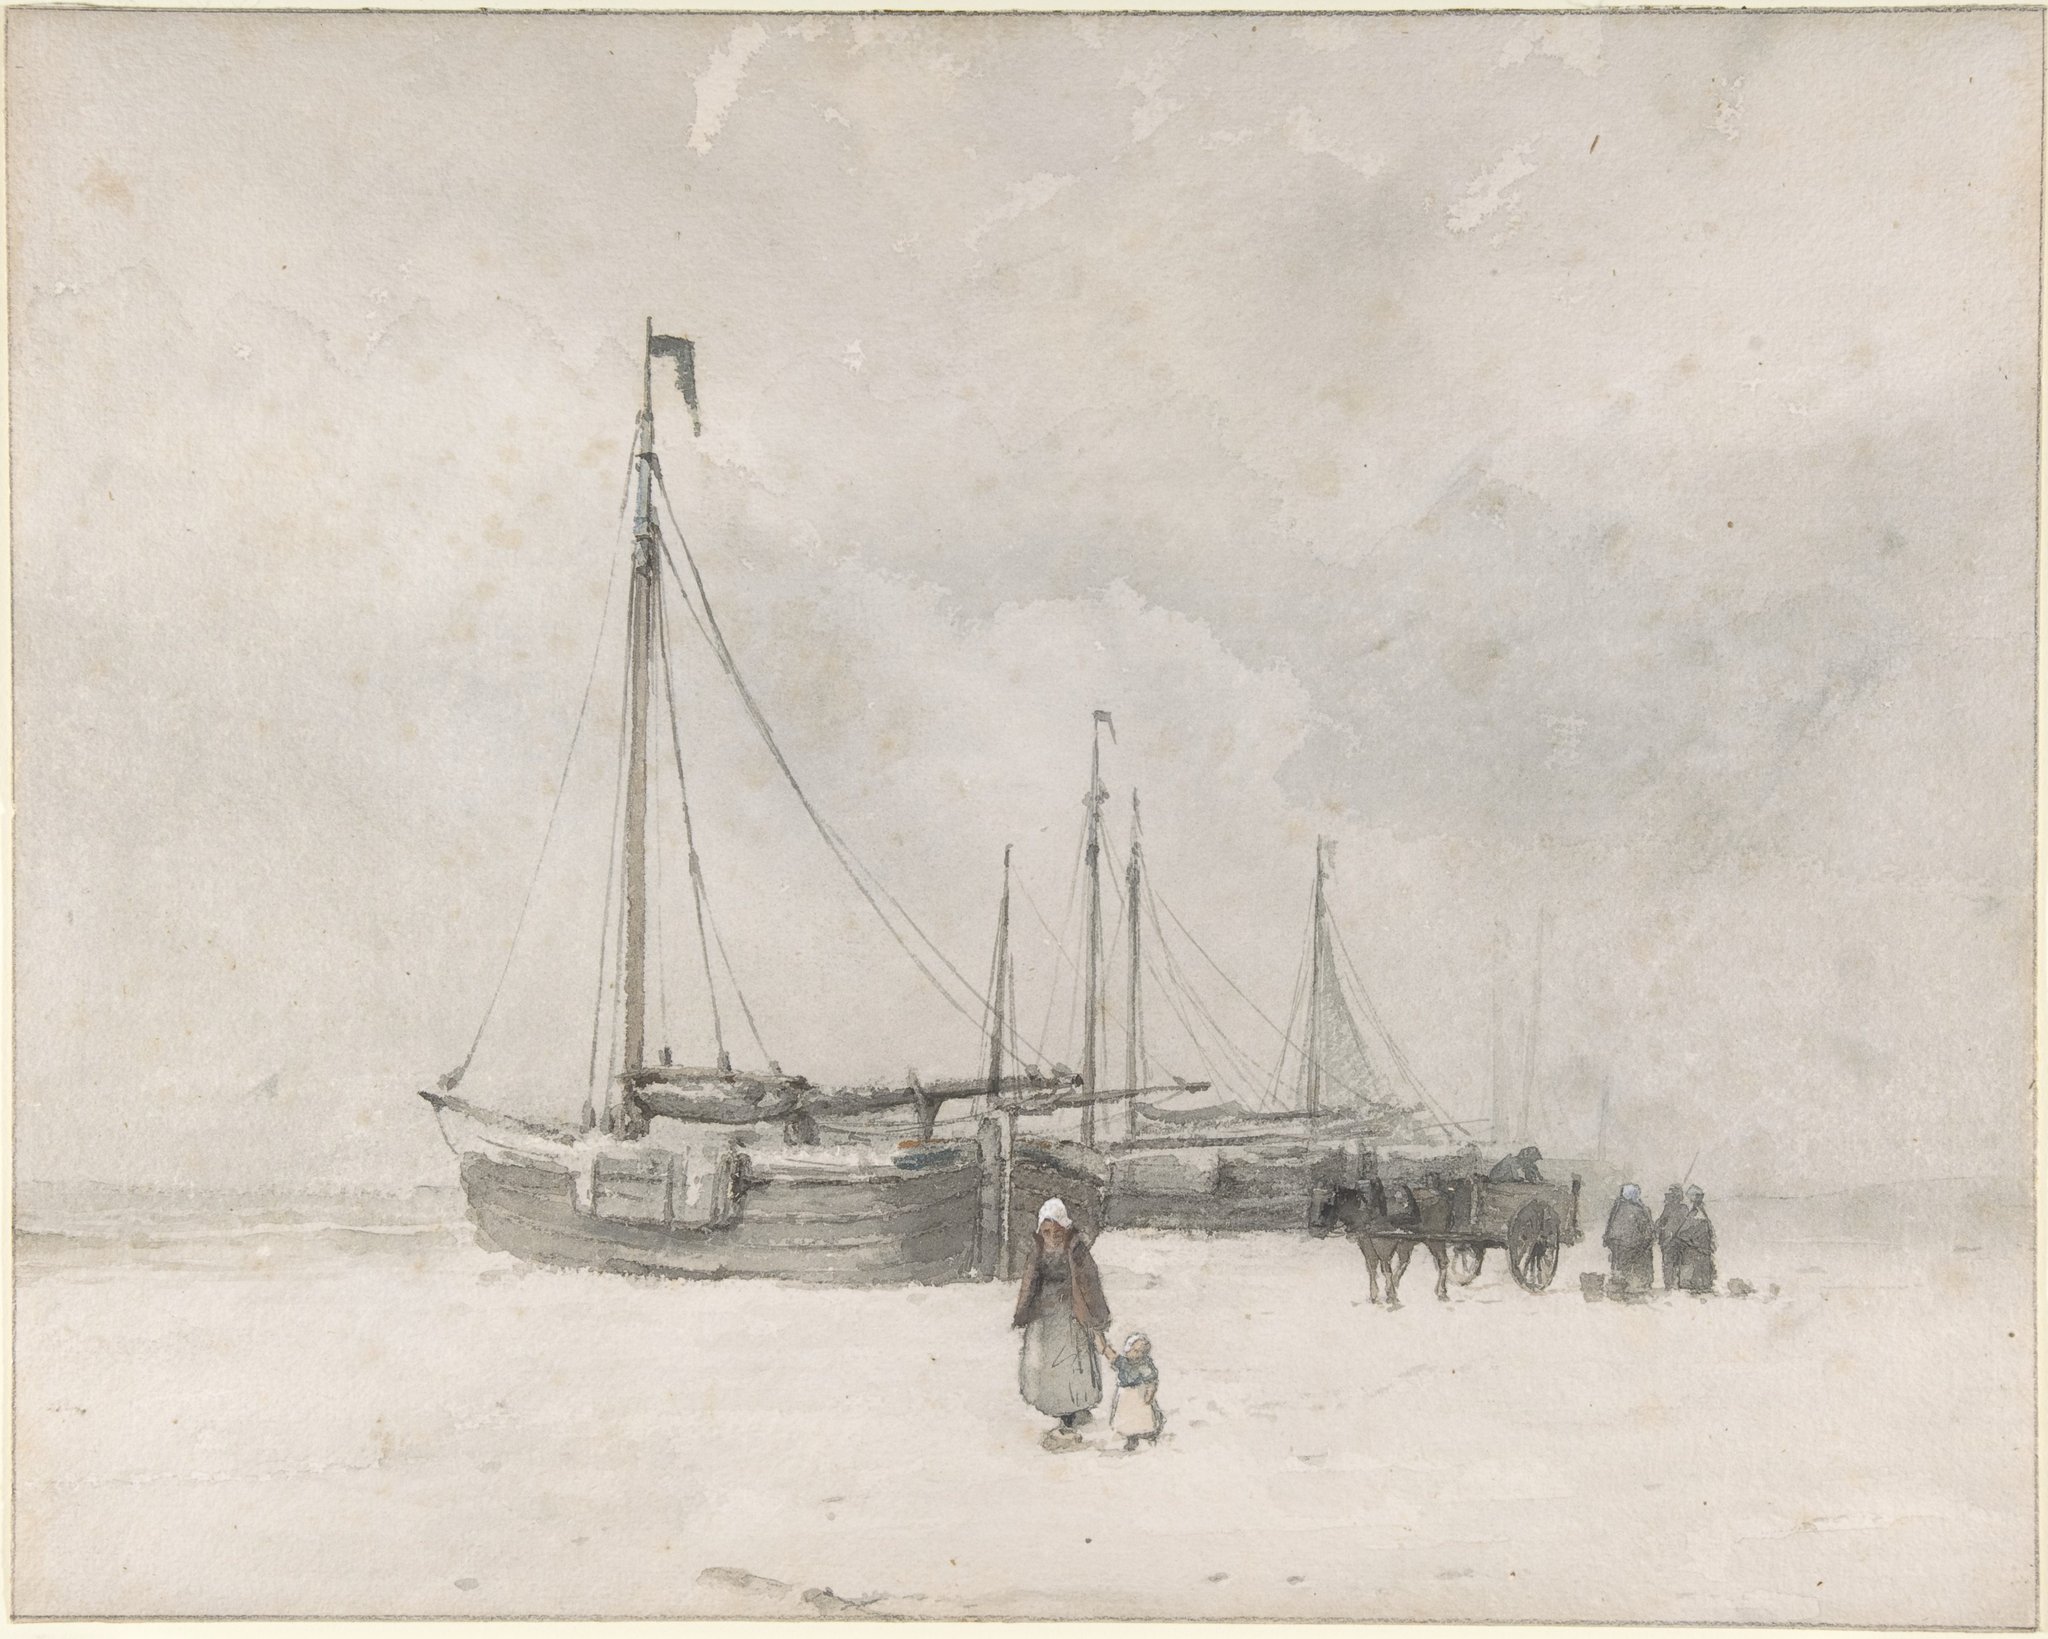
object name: drawing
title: Fishing Boats on the Beach in Winter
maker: anton mauve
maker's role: artist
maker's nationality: dutch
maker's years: 1838-1888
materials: paint, chalk, watercolor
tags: horses,beaches,winter,boats